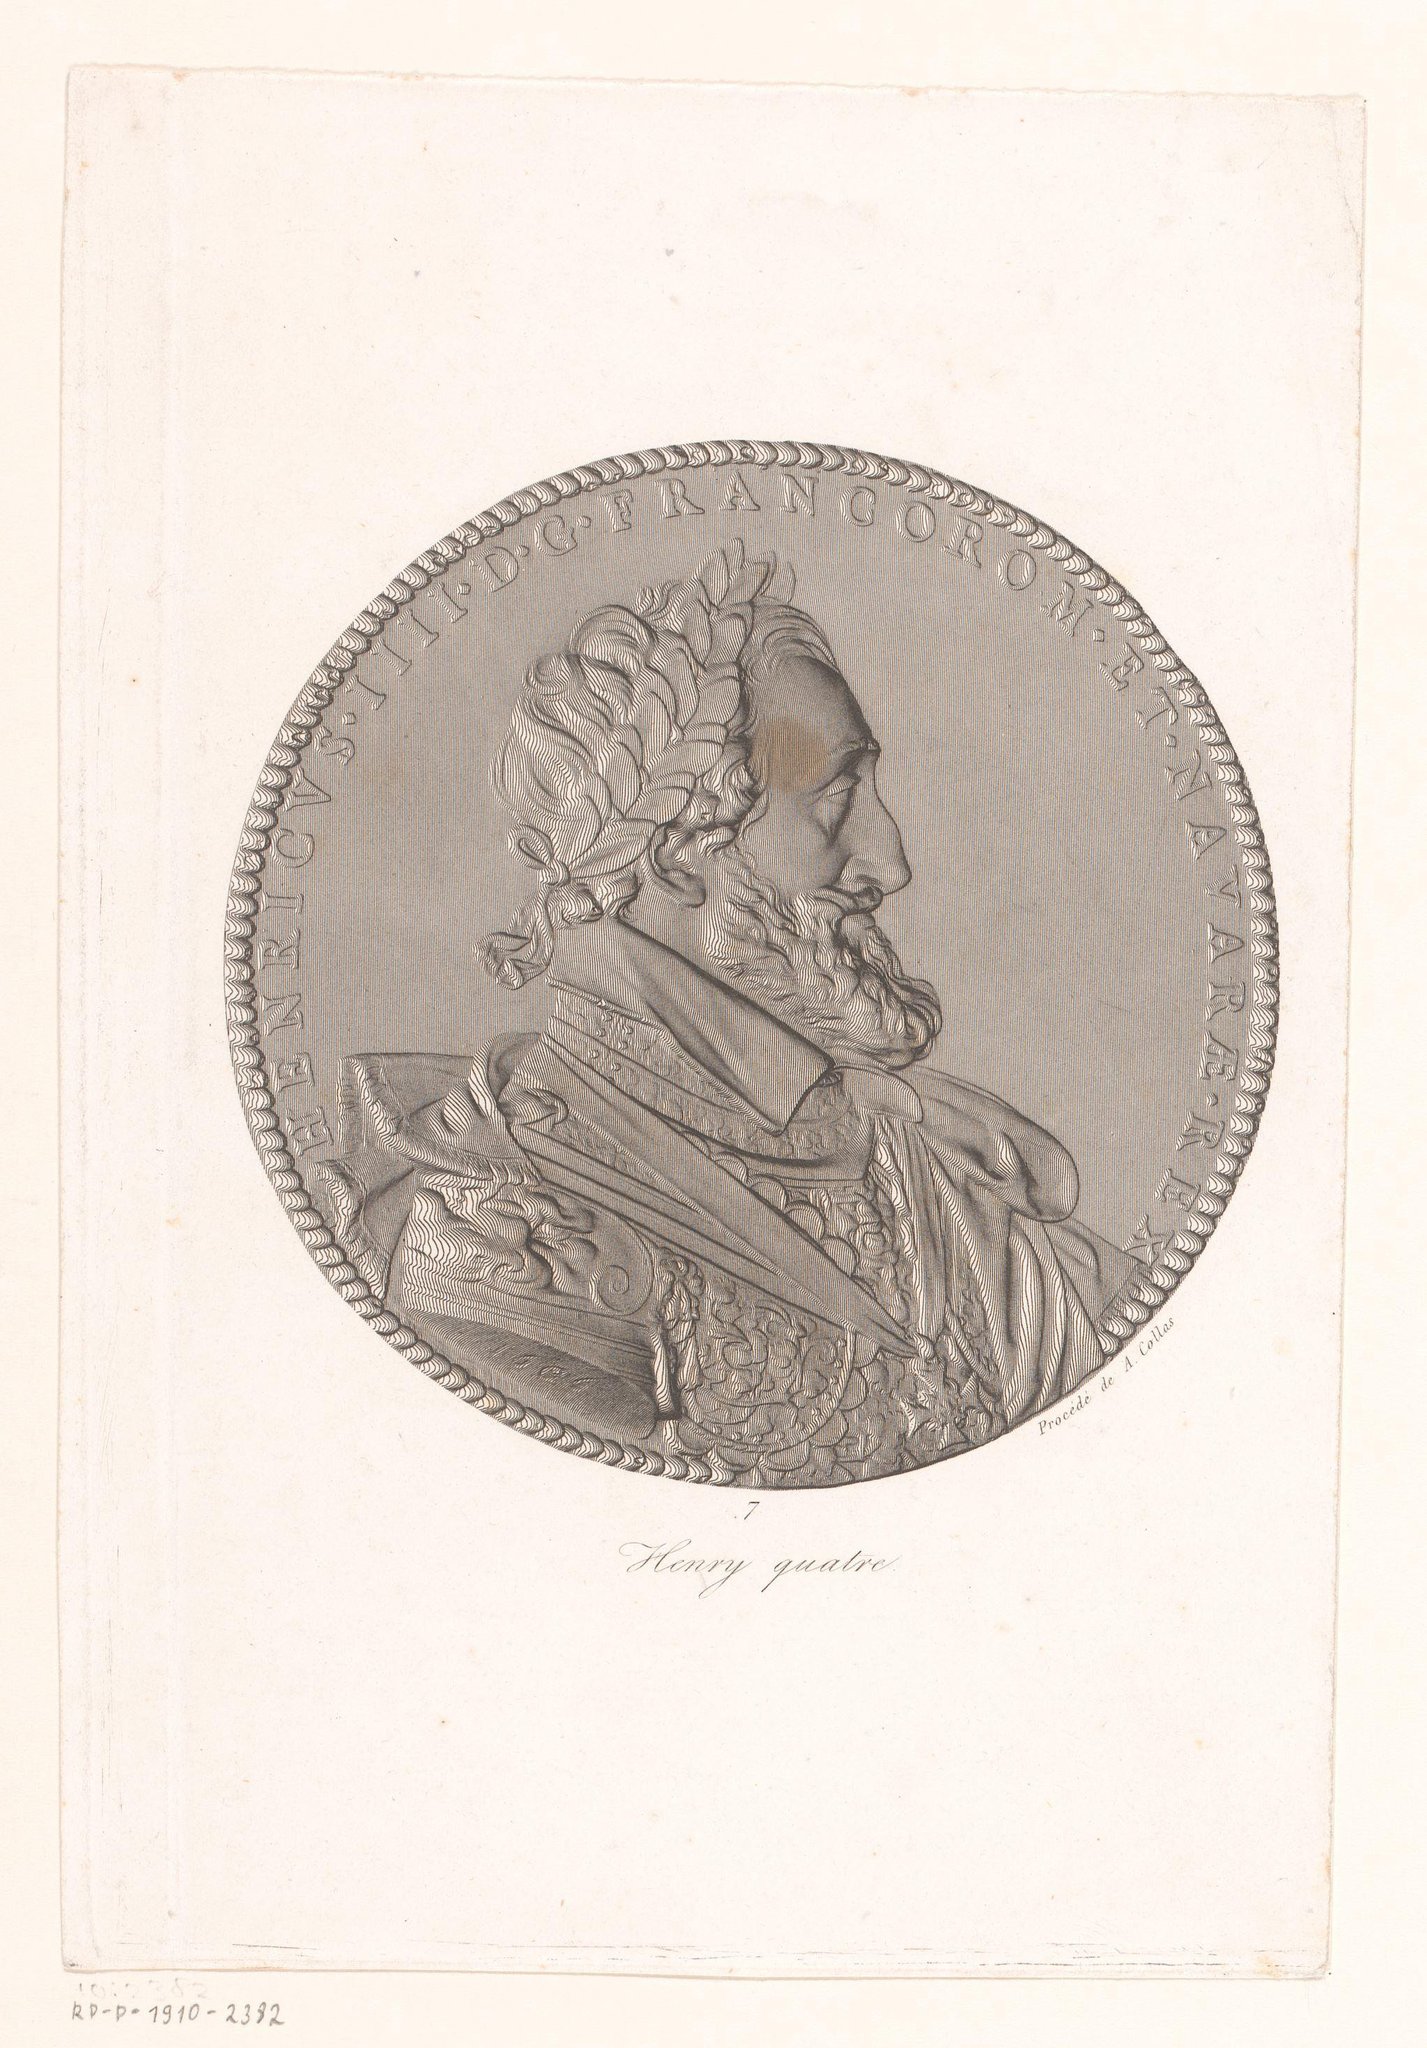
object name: print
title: Portret van Marie Antoinette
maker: h. delpierre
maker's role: draughtsman, painter, print maker, printer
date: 1800-1899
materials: paper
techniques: engraving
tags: vienna, paris, marie antoinette, historical persons, queen, pearl; pearl necklace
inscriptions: collector's mark: Lugt 2228